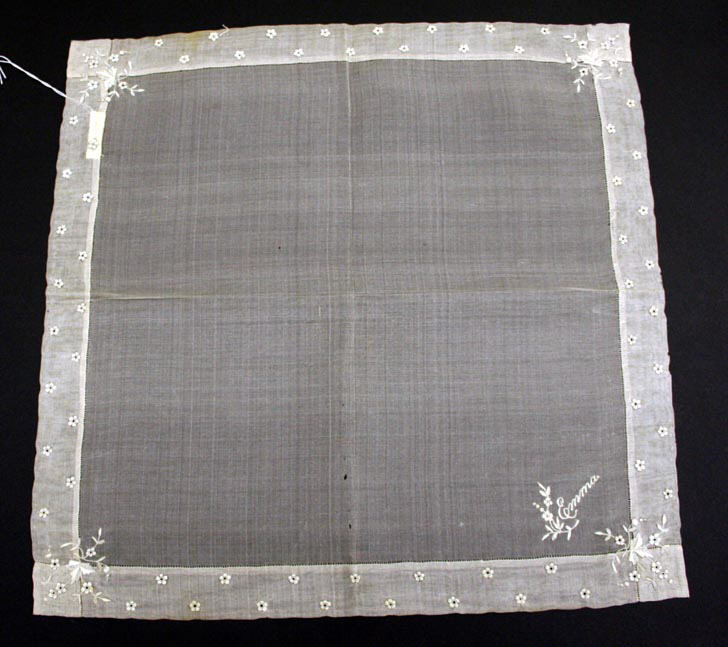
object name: handkerchief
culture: german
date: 1893